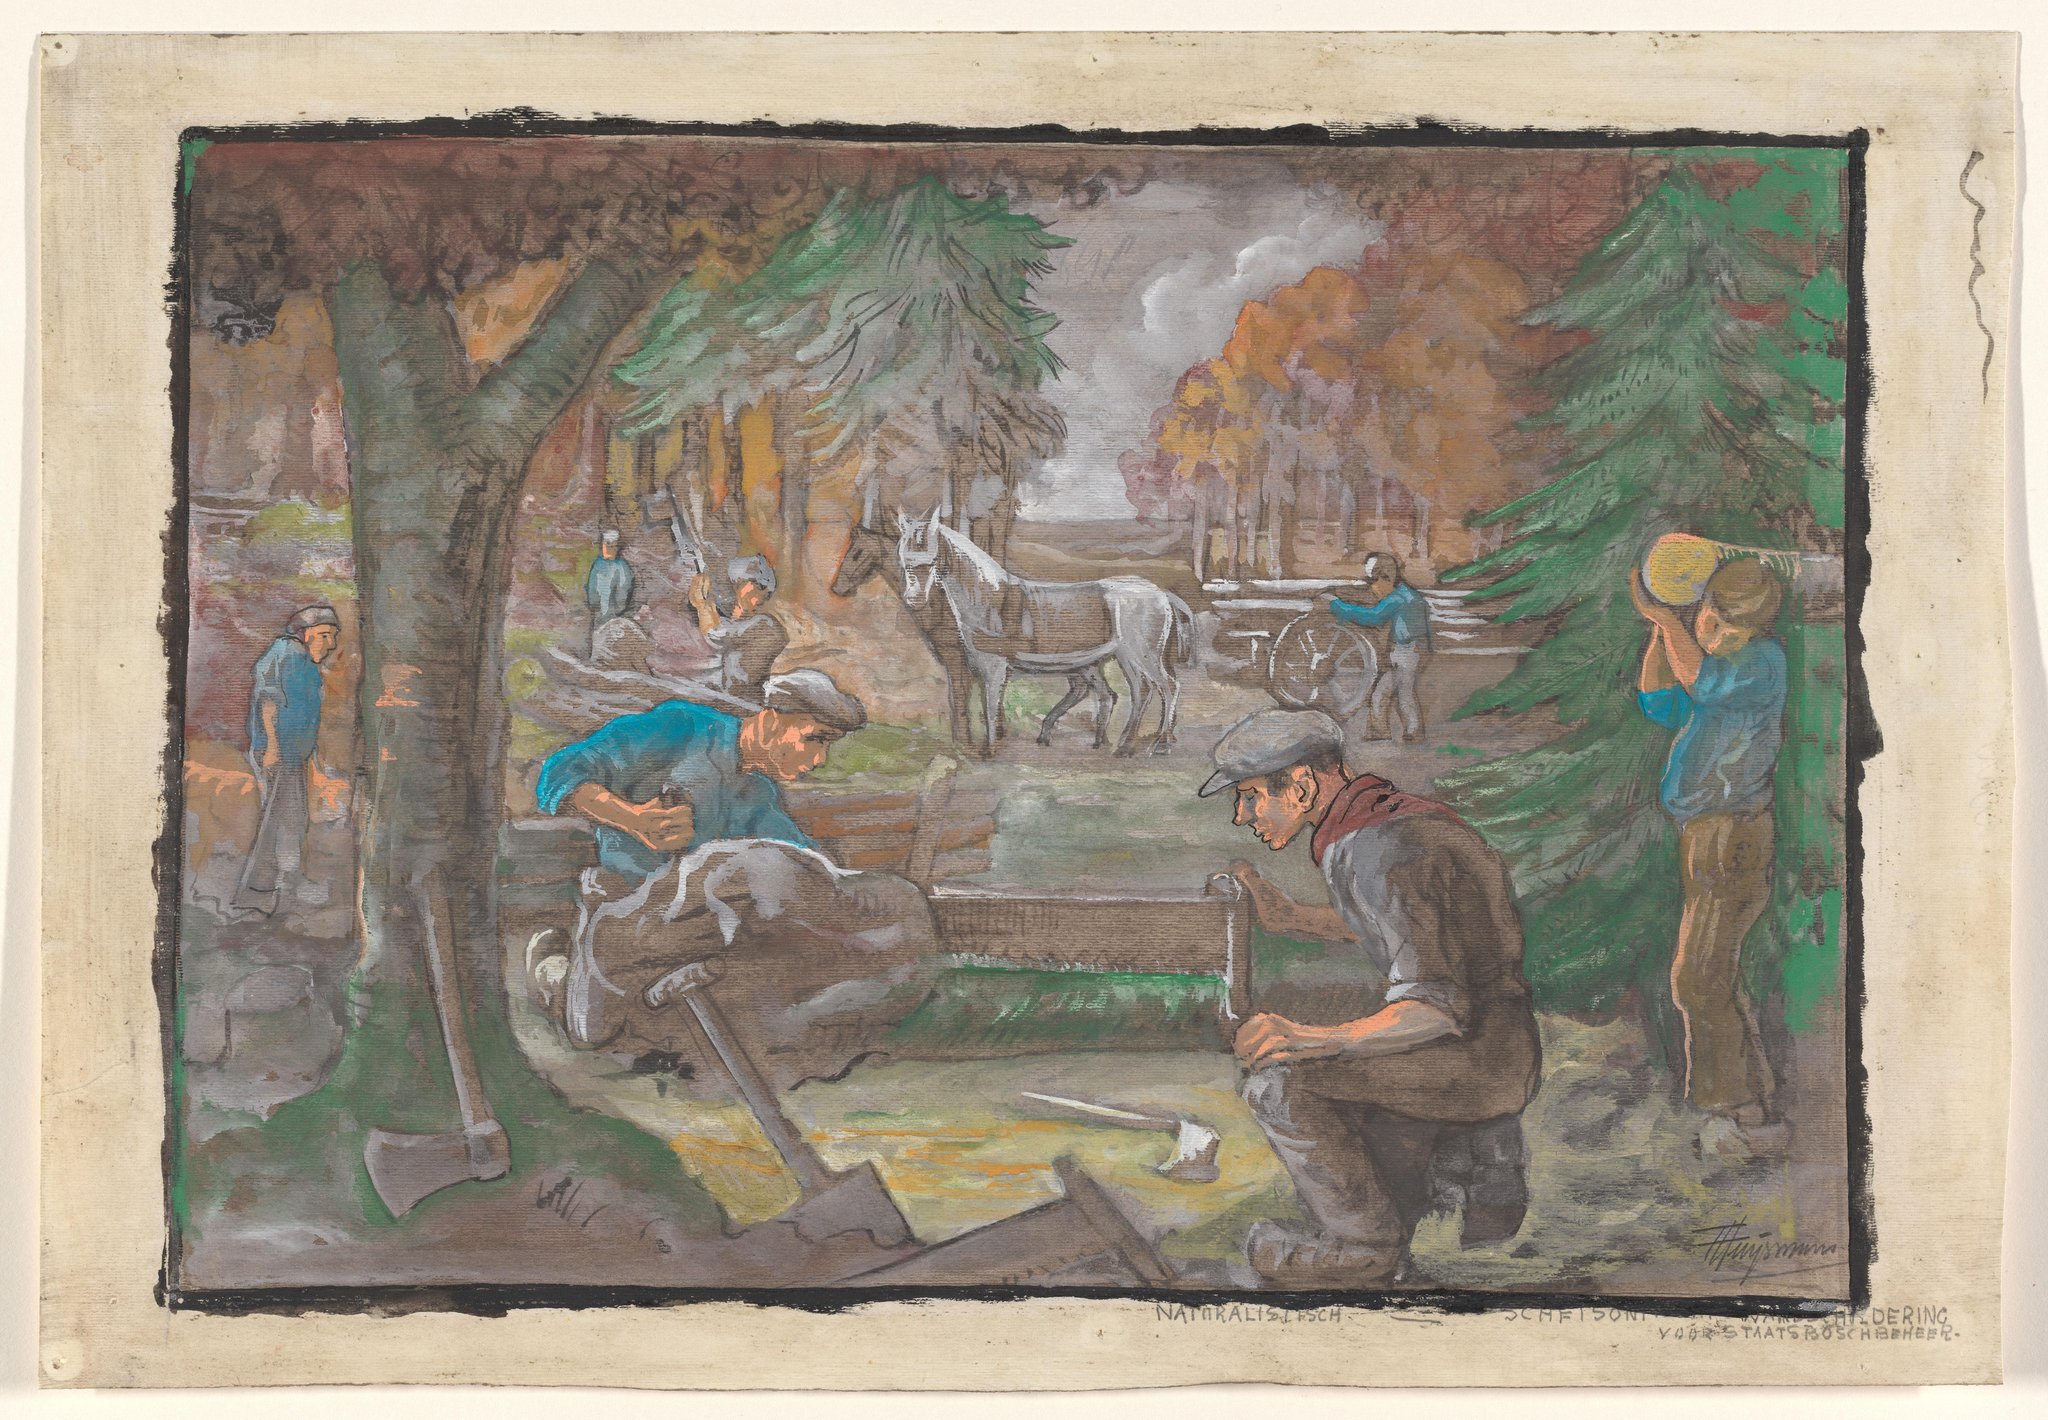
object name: drawing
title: Houthakkers in het bos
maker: frans huysmans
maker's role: draughtsman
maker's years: 1885-1954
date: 1938-1995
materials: gouache, ink, paper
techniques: brush, pen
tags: woodcutting, woodcutter ~ forestry, forest, wood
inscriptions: sticker, verso, plakken: Nederlandsch steuncomité voor beeldende kunstenaren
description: Ontwerp voor een wandschildering voor Staatsbosbeheer.